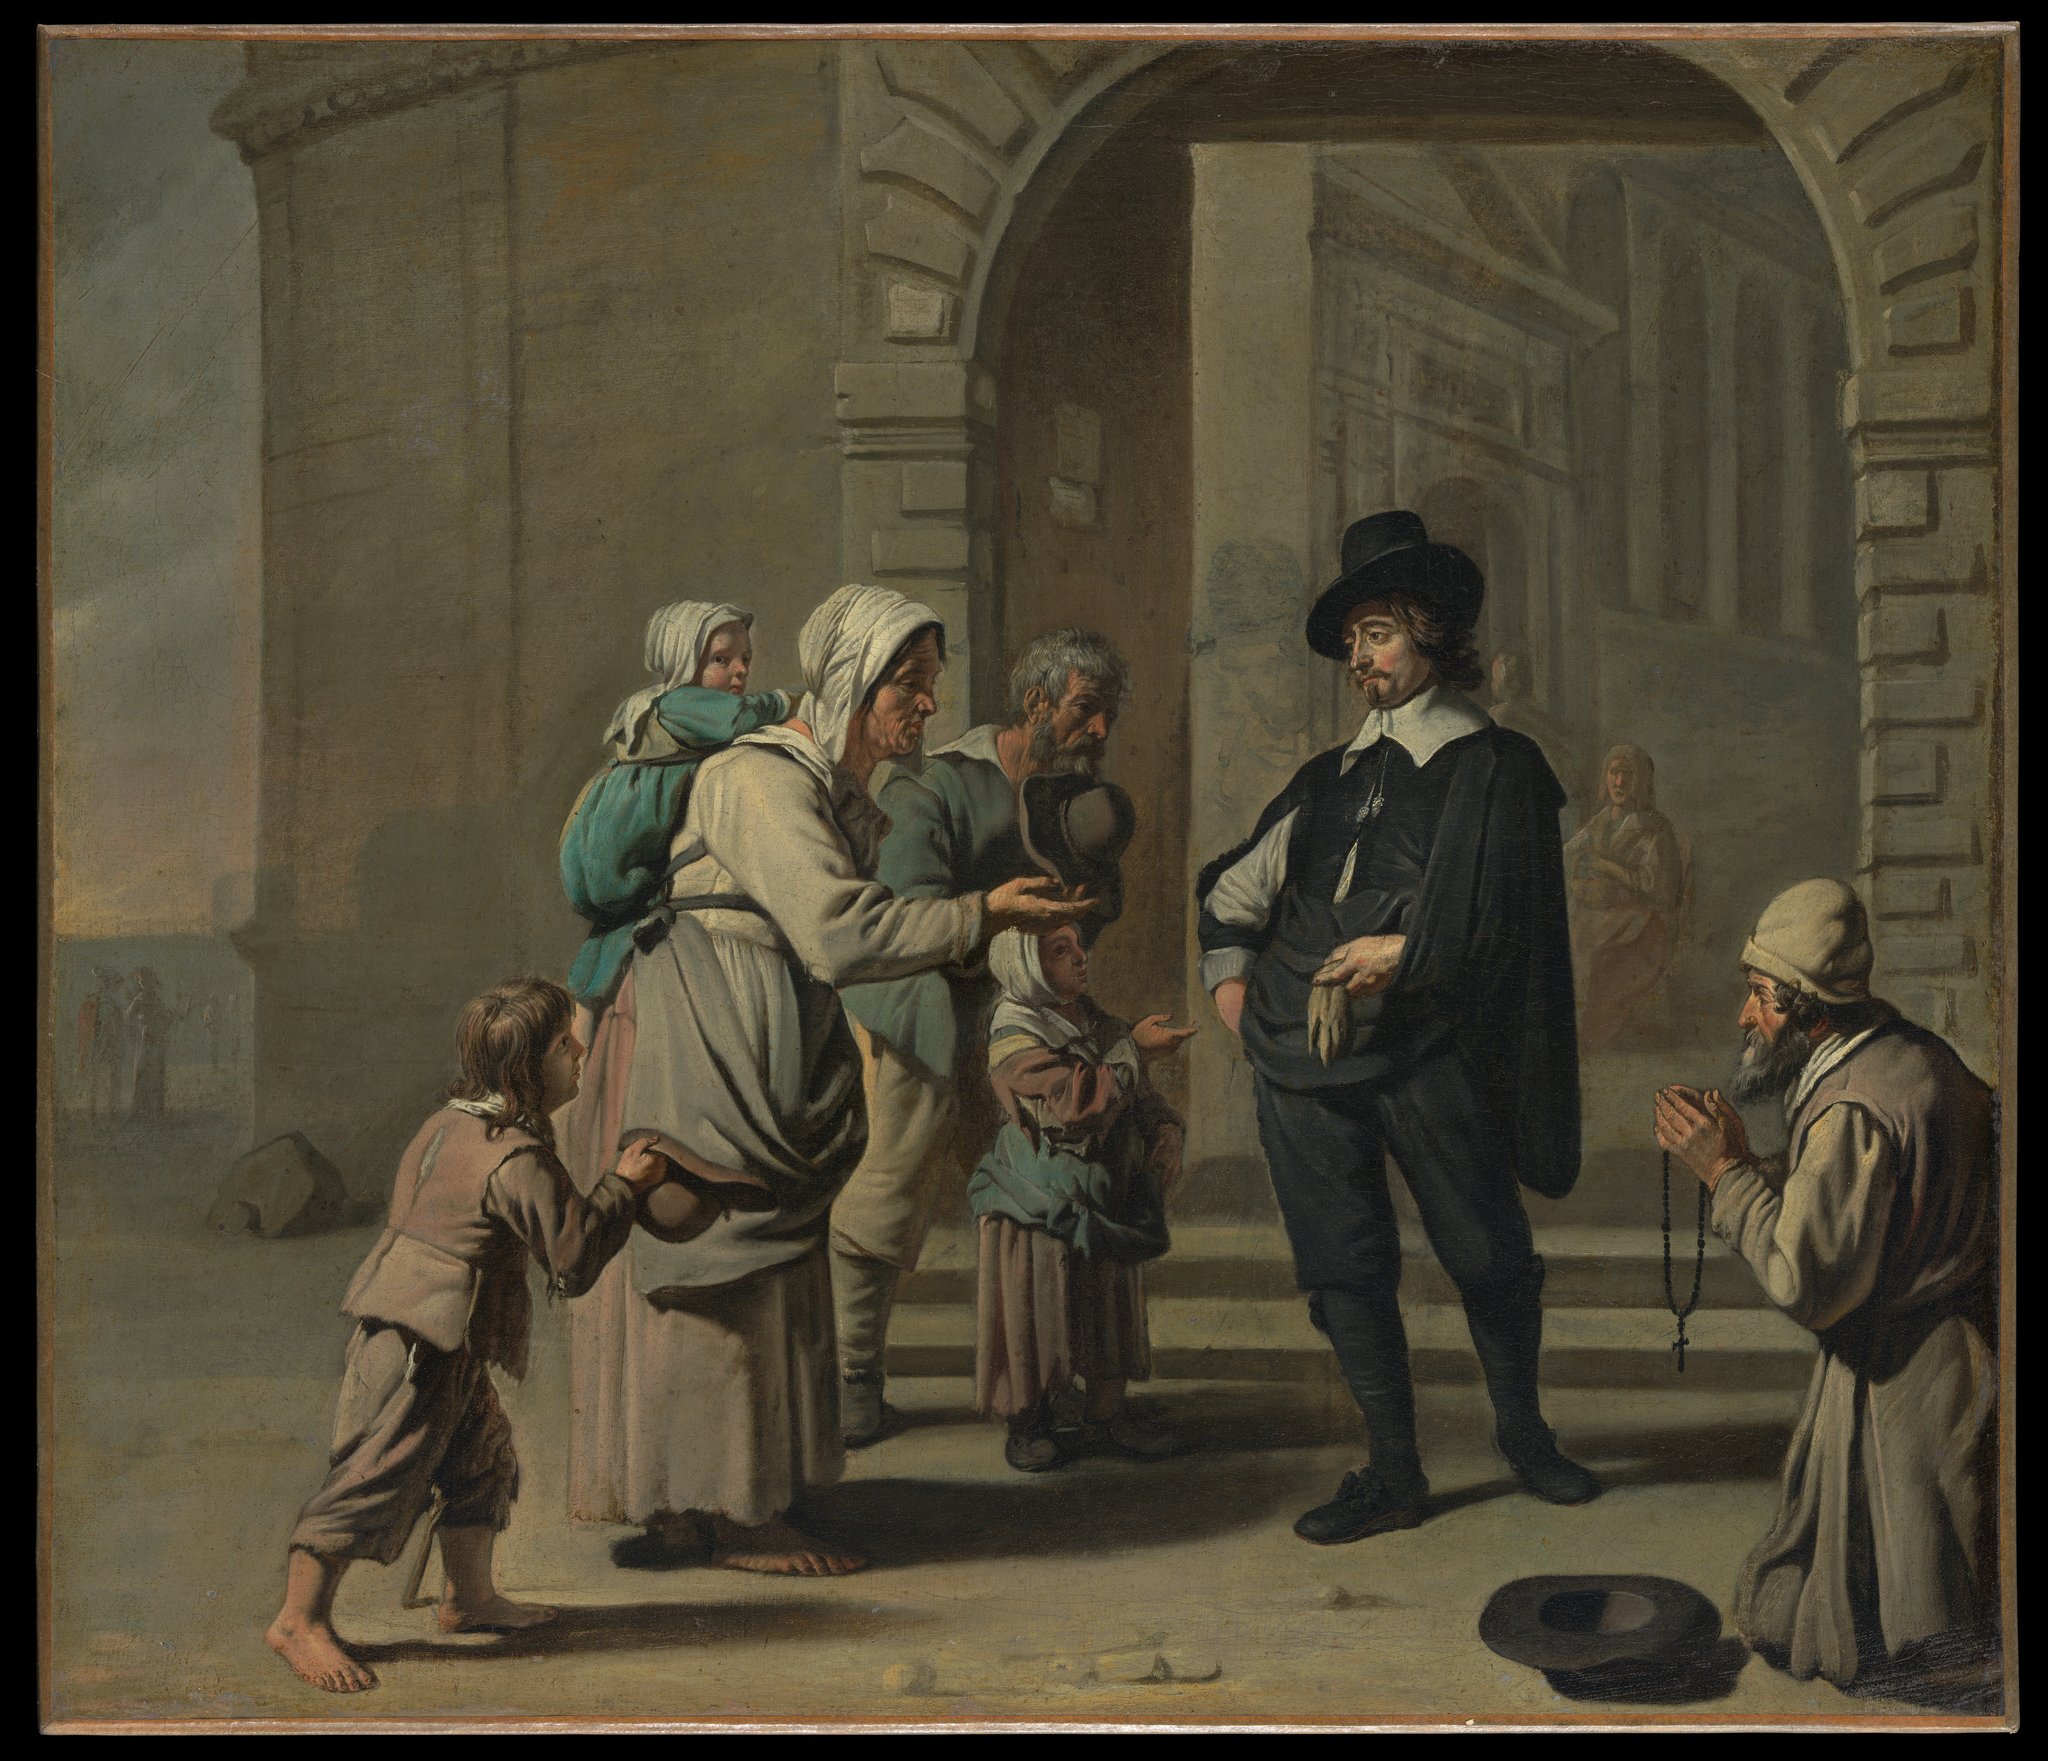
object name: painting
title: Beggars at a Doorway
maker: master of the béguins, french or flemish, active 1650–60 (possibly abraham willemsens, flemish, active by 1627, died 1672)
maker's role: artist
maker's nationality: french, flemish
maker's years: 1627-1672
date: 1650-1660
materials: canvas, oil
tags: children,men,women